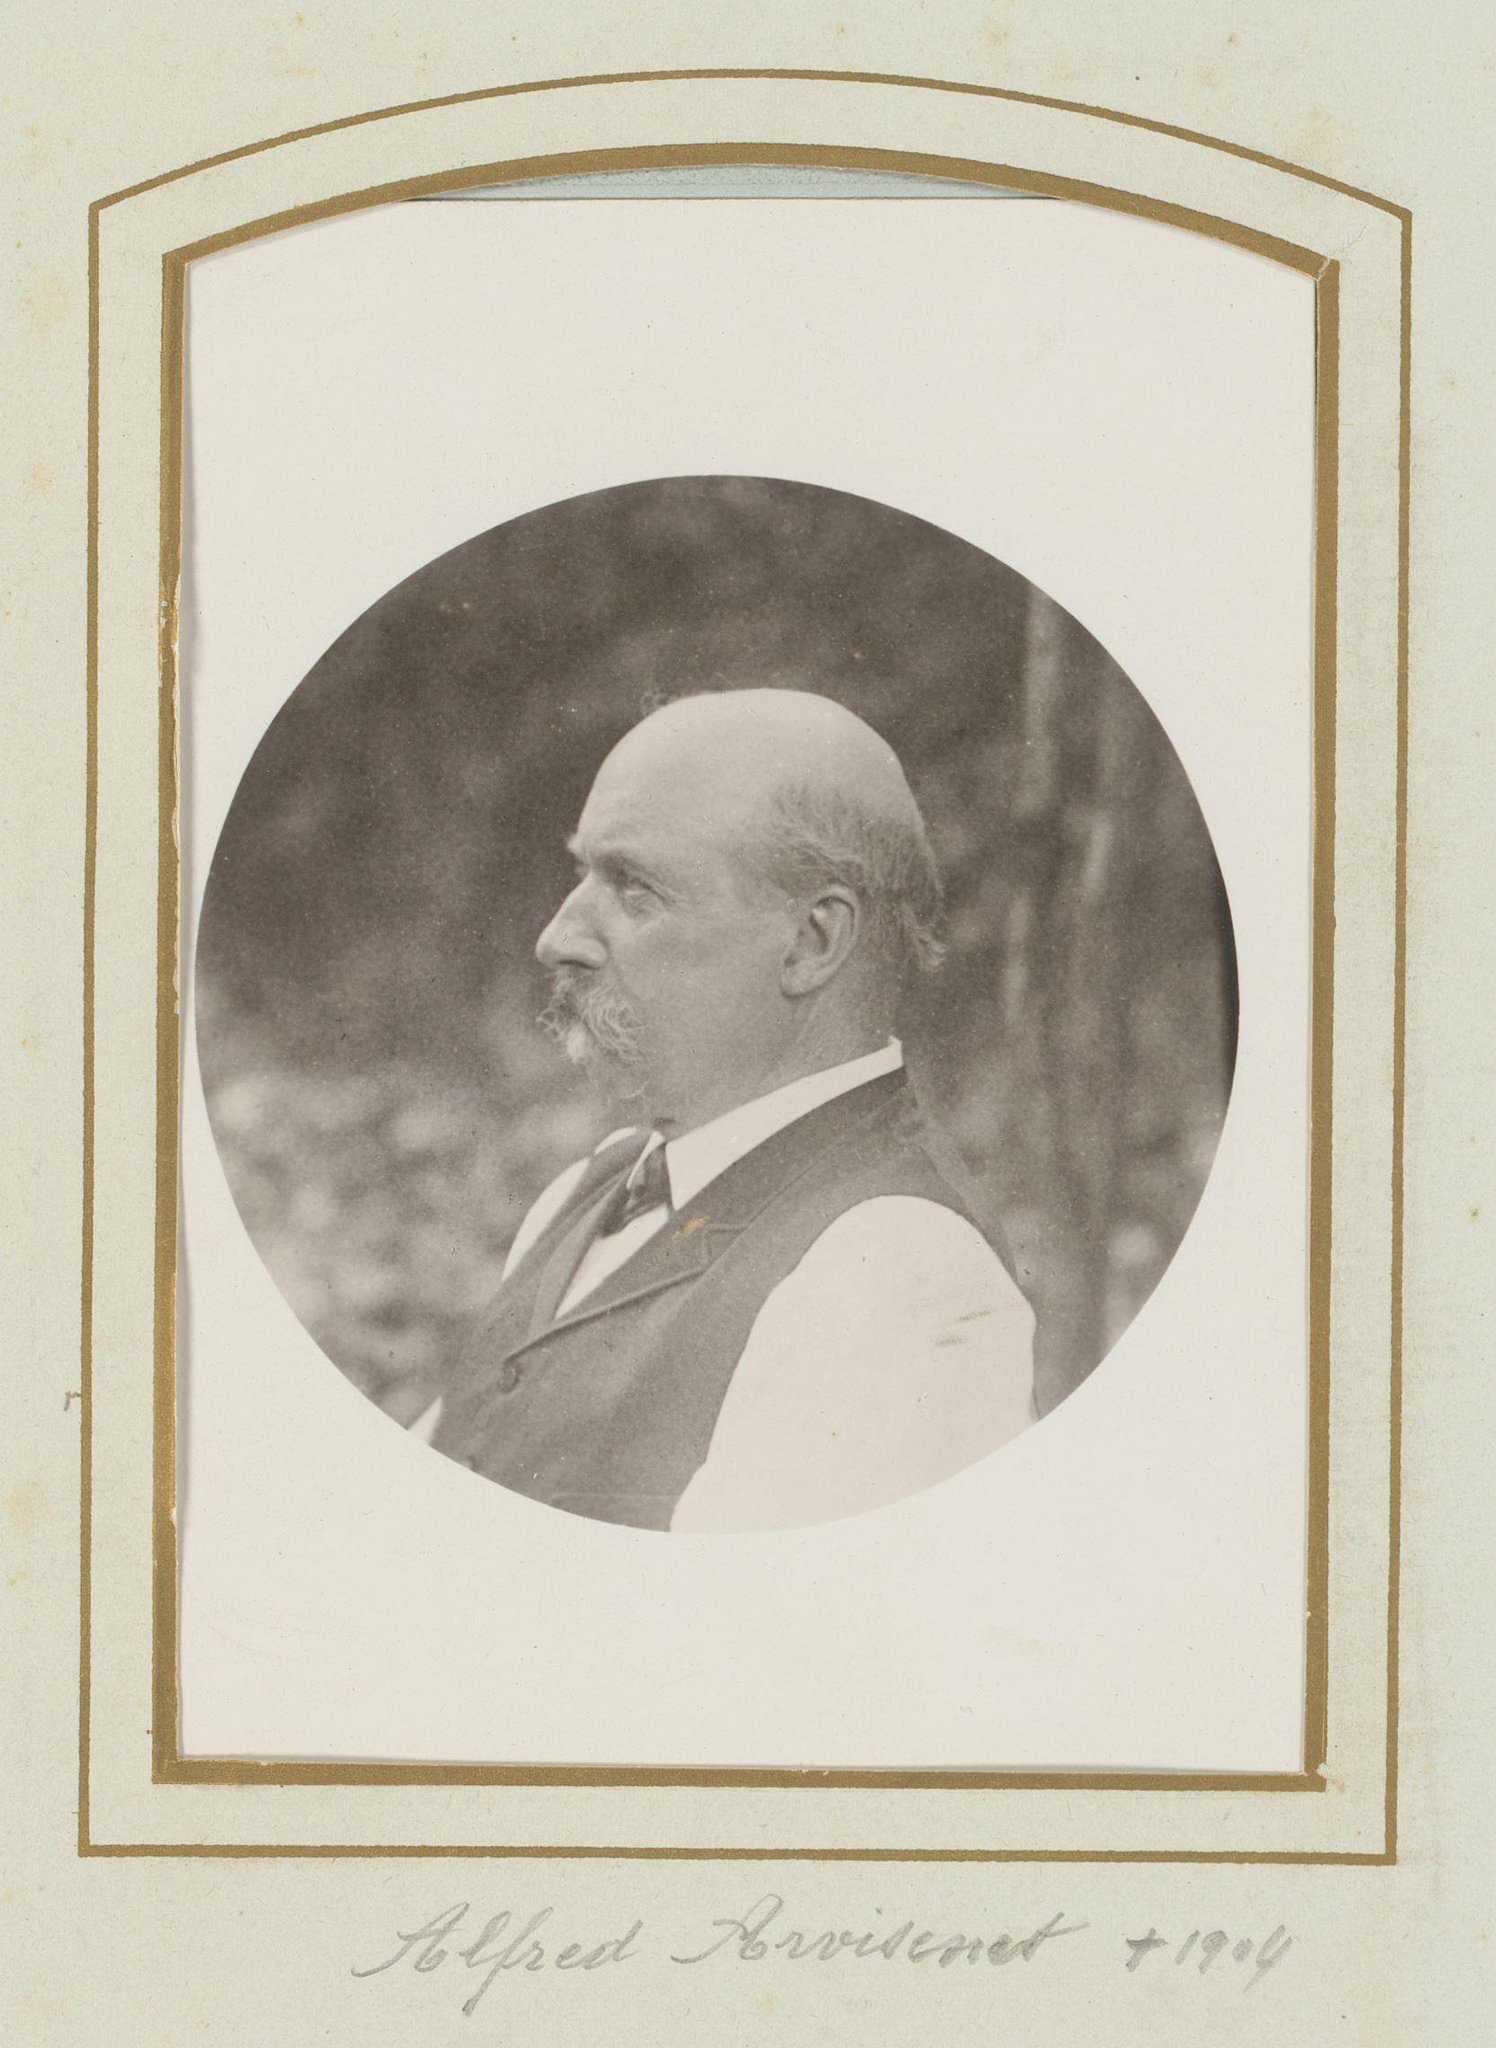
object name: photograph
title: Portret van Alfred Arvisenet, en profil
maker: Anonymous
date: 1915-1930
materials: cardboard, photographic support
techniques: gelatin silver print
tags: moustache, historical persons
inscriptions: name: ‘Alfred Arvisenet +1904’